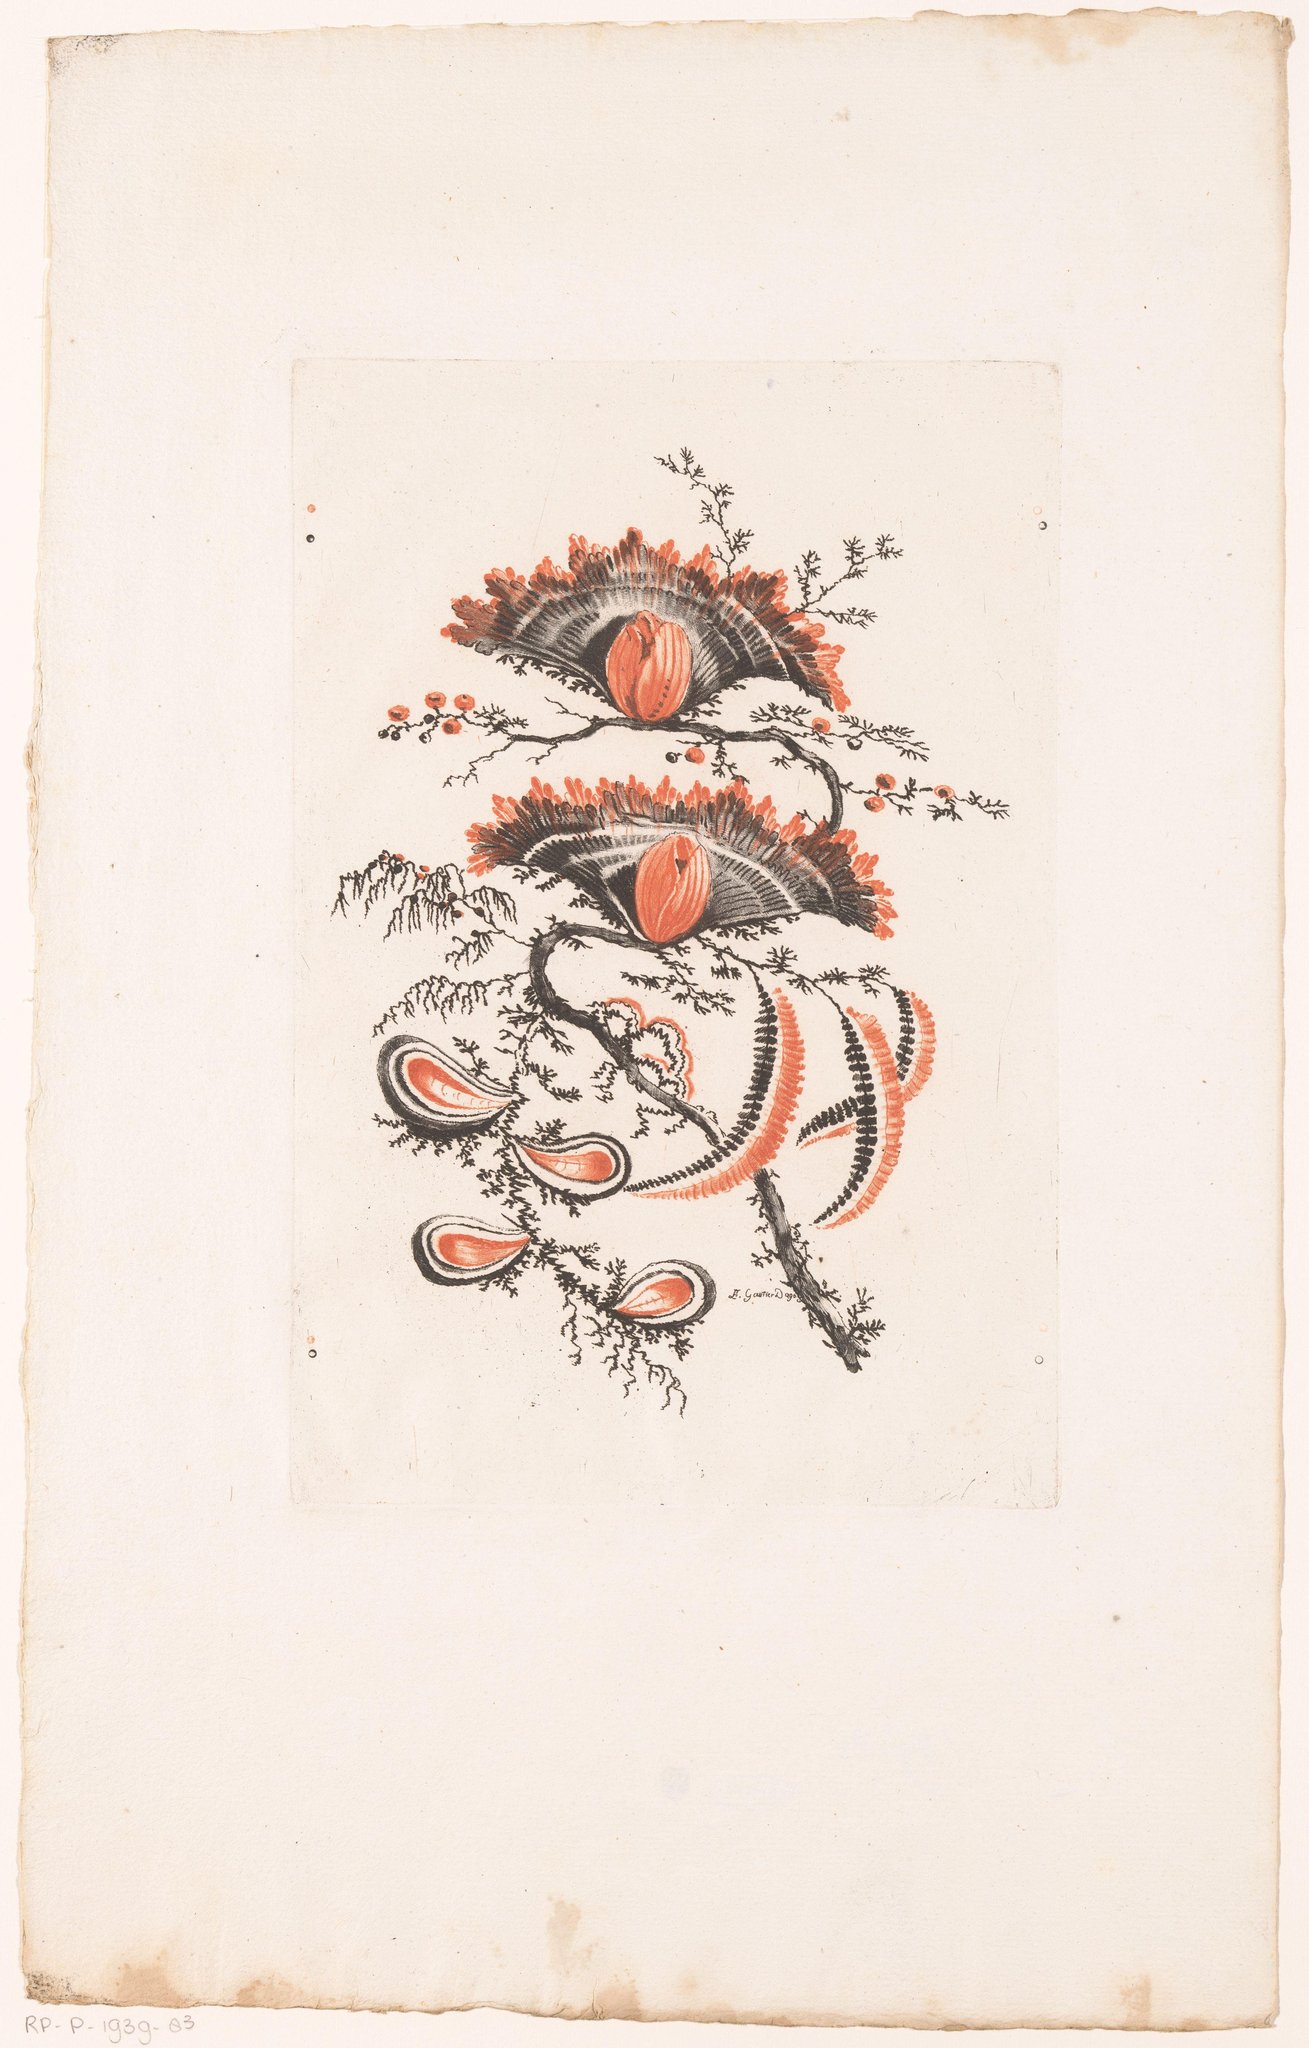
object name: ornament print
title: Waaiervormige bloemen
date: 1770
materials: paper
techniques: etching, roulette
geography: paris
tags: fabulous flowers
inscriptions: collector's mark: Lugt 2228, collector's mark: Lugt 2760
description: Waaiervormige bloemen en bloemen in halve maan-vorm.